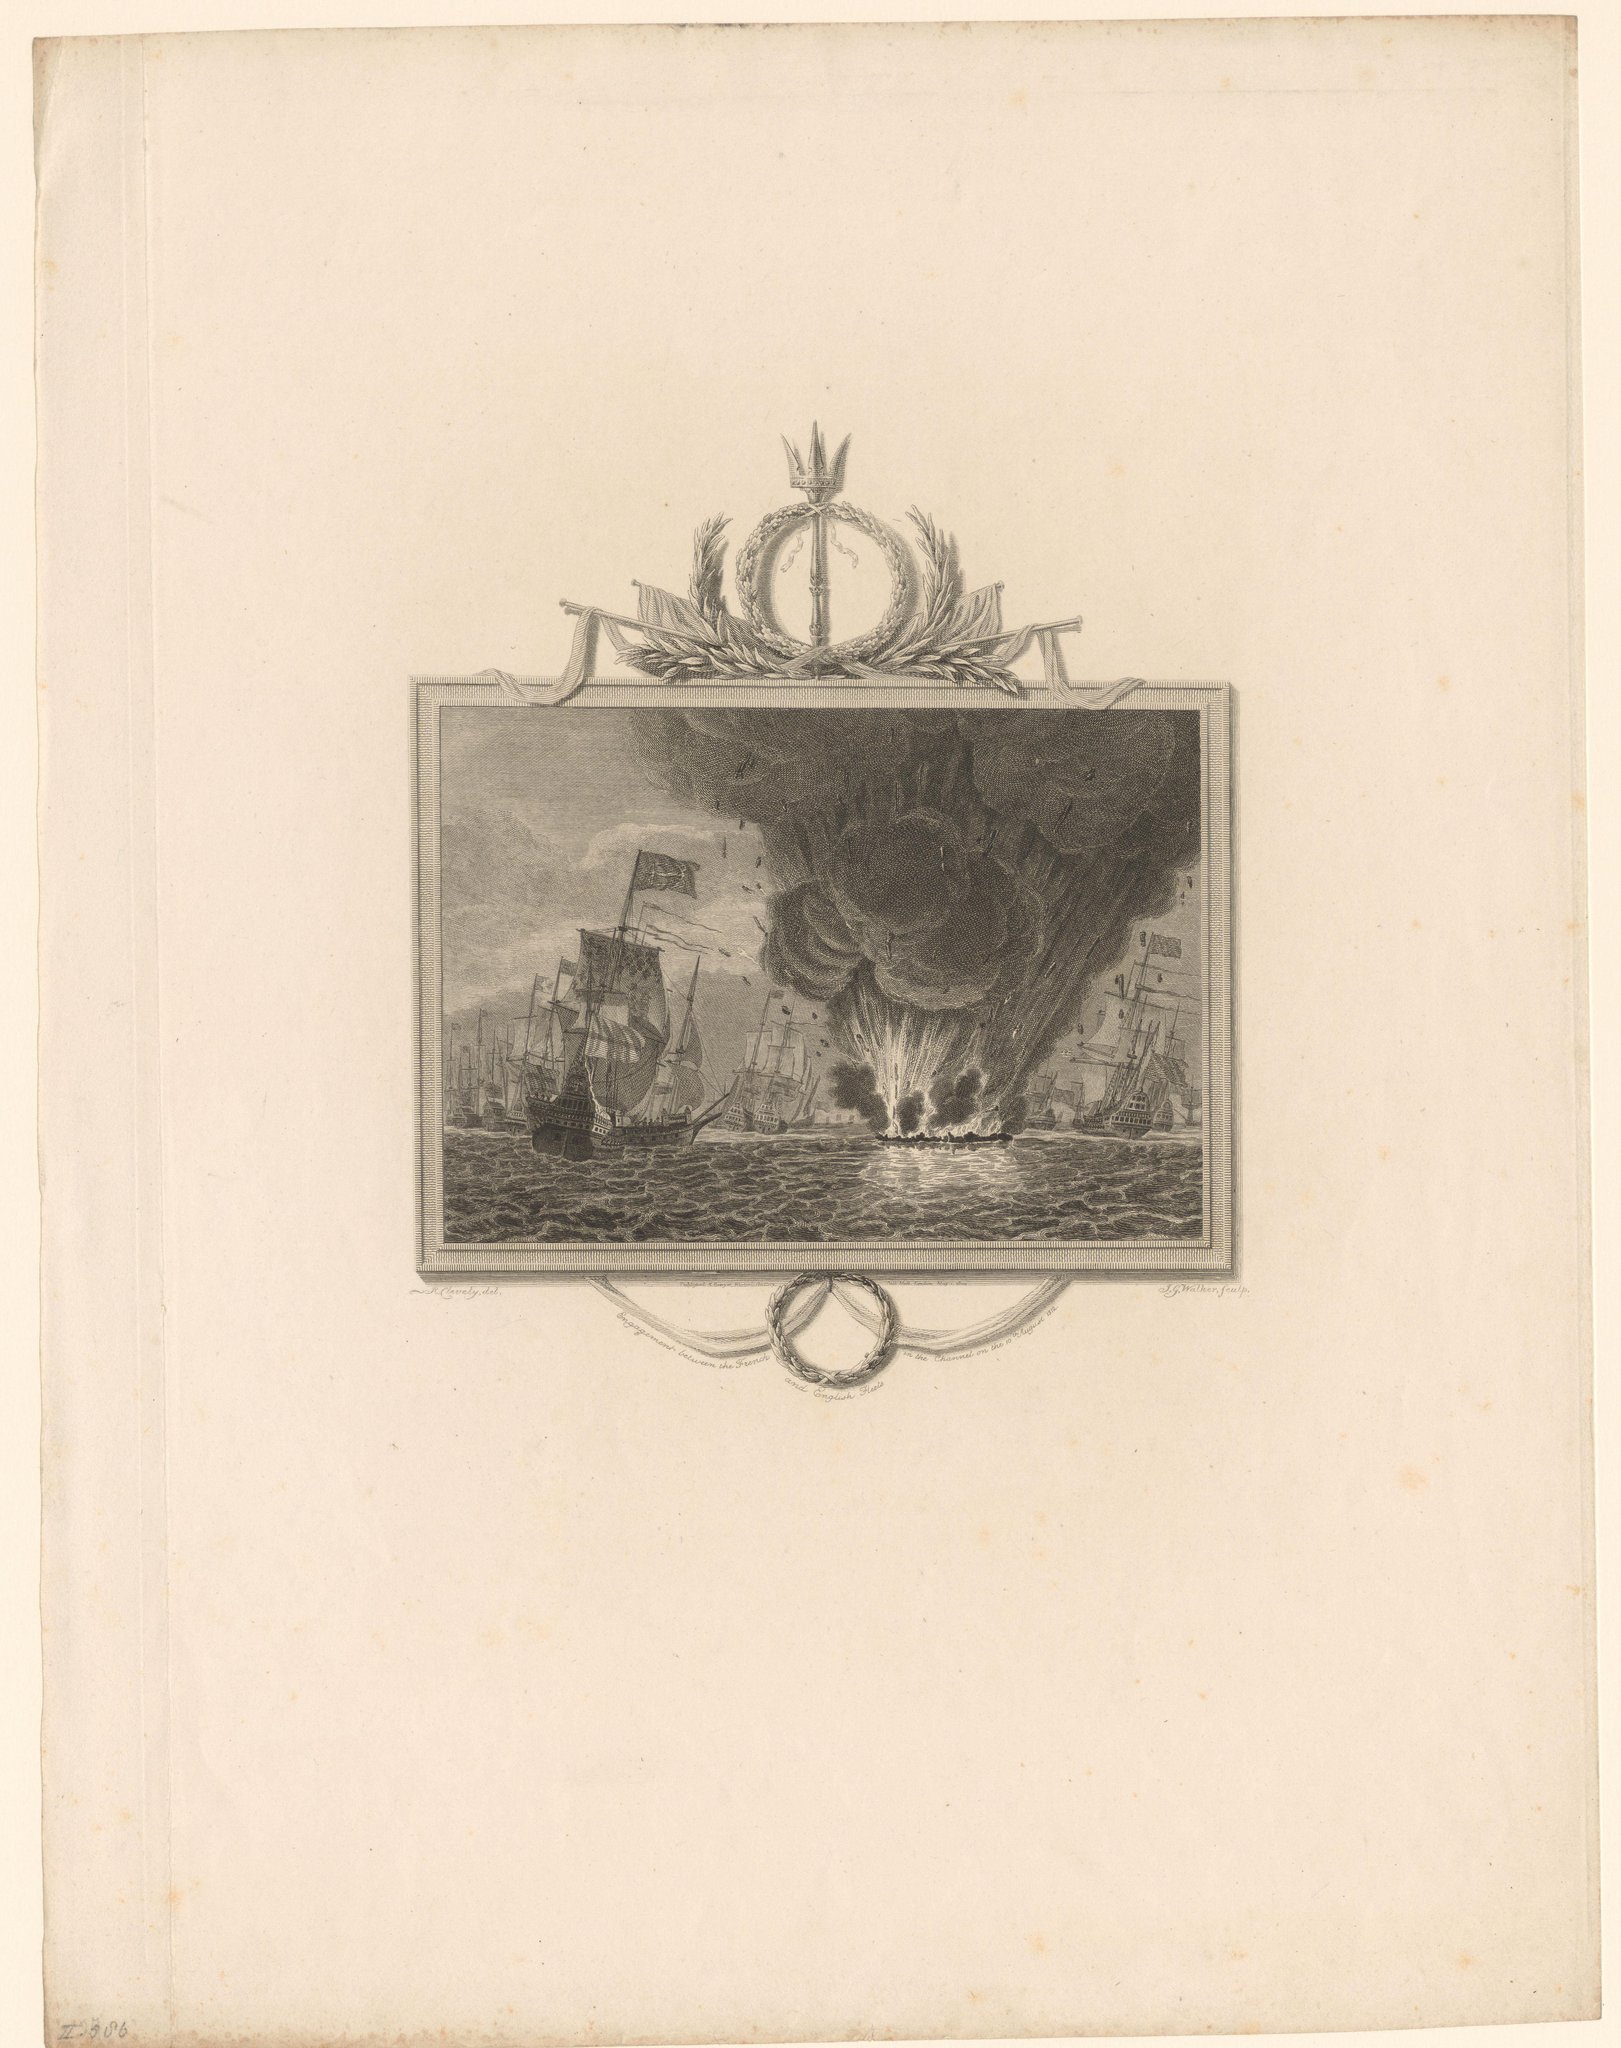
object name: print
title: Engagement between the French and English Fleets in the Channel on 10 August 1512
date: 1802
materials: paper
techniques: engraving, etching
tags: battle (+ naval force), projectiles, explosives, etc., english channel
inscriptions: collector's mark: Lugt 2228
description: Deze prent is gebruikt in: The History of England. Londen: Robert Bowyer, 1802. Deze editie is gebaseerd op David Hume's uitgave van 'The History of England', waarvan het eerste deel verscheen in 1754 en het laatste in 1762.